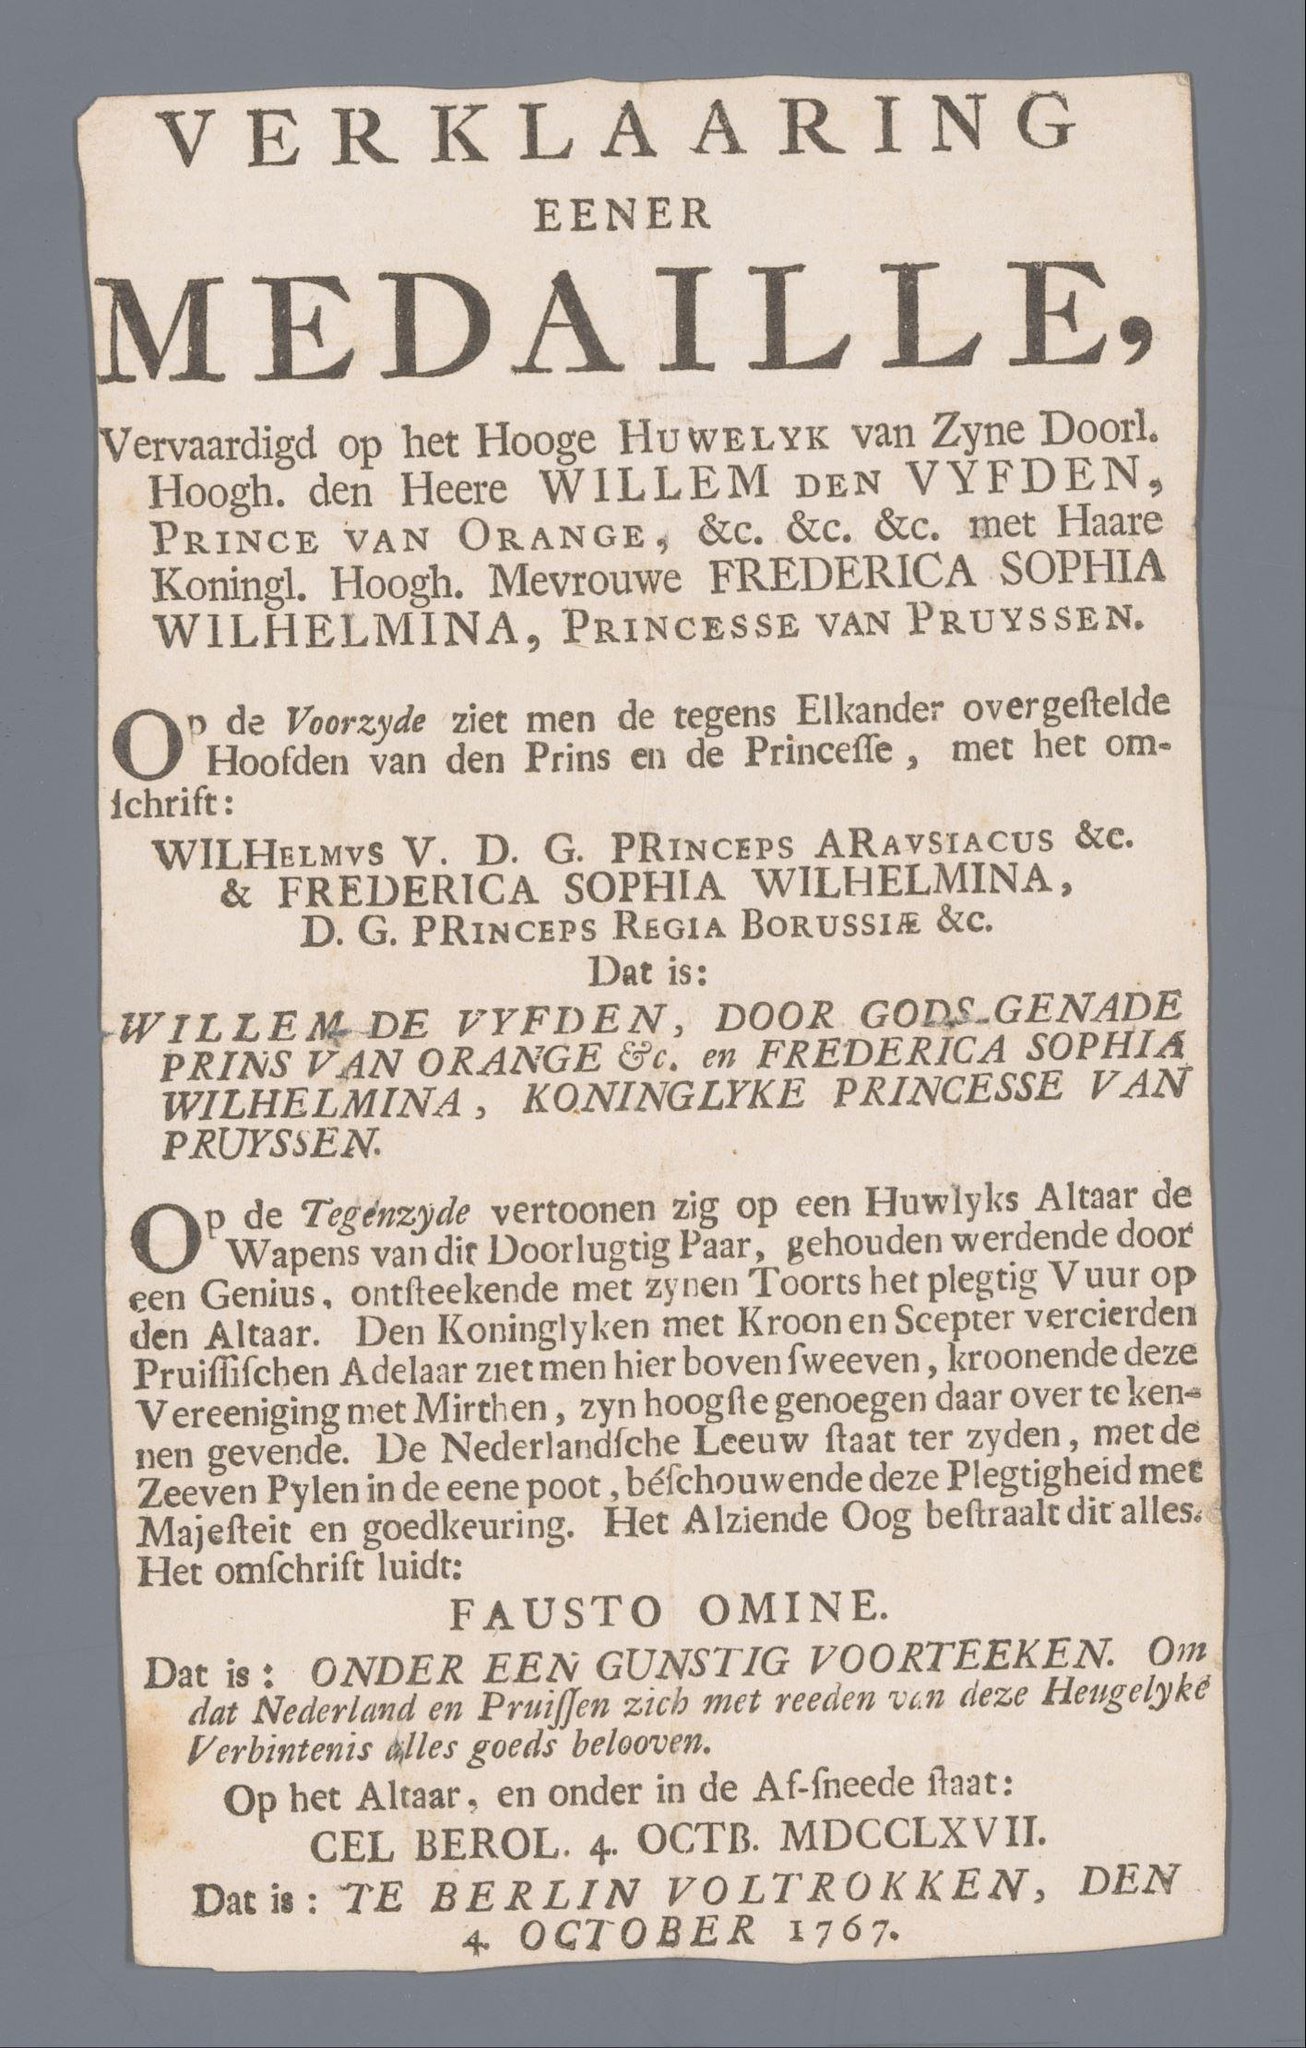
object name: pamphlet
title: Verklaring van de penning door Johan George Holtzhey geslagen op het huwelijk van Willem V, prins van Oranje-Nassau en Wilhelmina Frederica Sophia van Pruisen te Berlijn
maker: Anonymous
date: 1767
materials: paper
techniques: printing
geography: amsterdam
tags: the hague, william v (prince of orange), berlin, painter, wilhelmina of prussia (princess of orange)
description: Eenzijdig, rechthoekig papier met opschrift, gedrukt in zwarte inkt. Keerzijde: letter A in zwarte inkt geschreven.